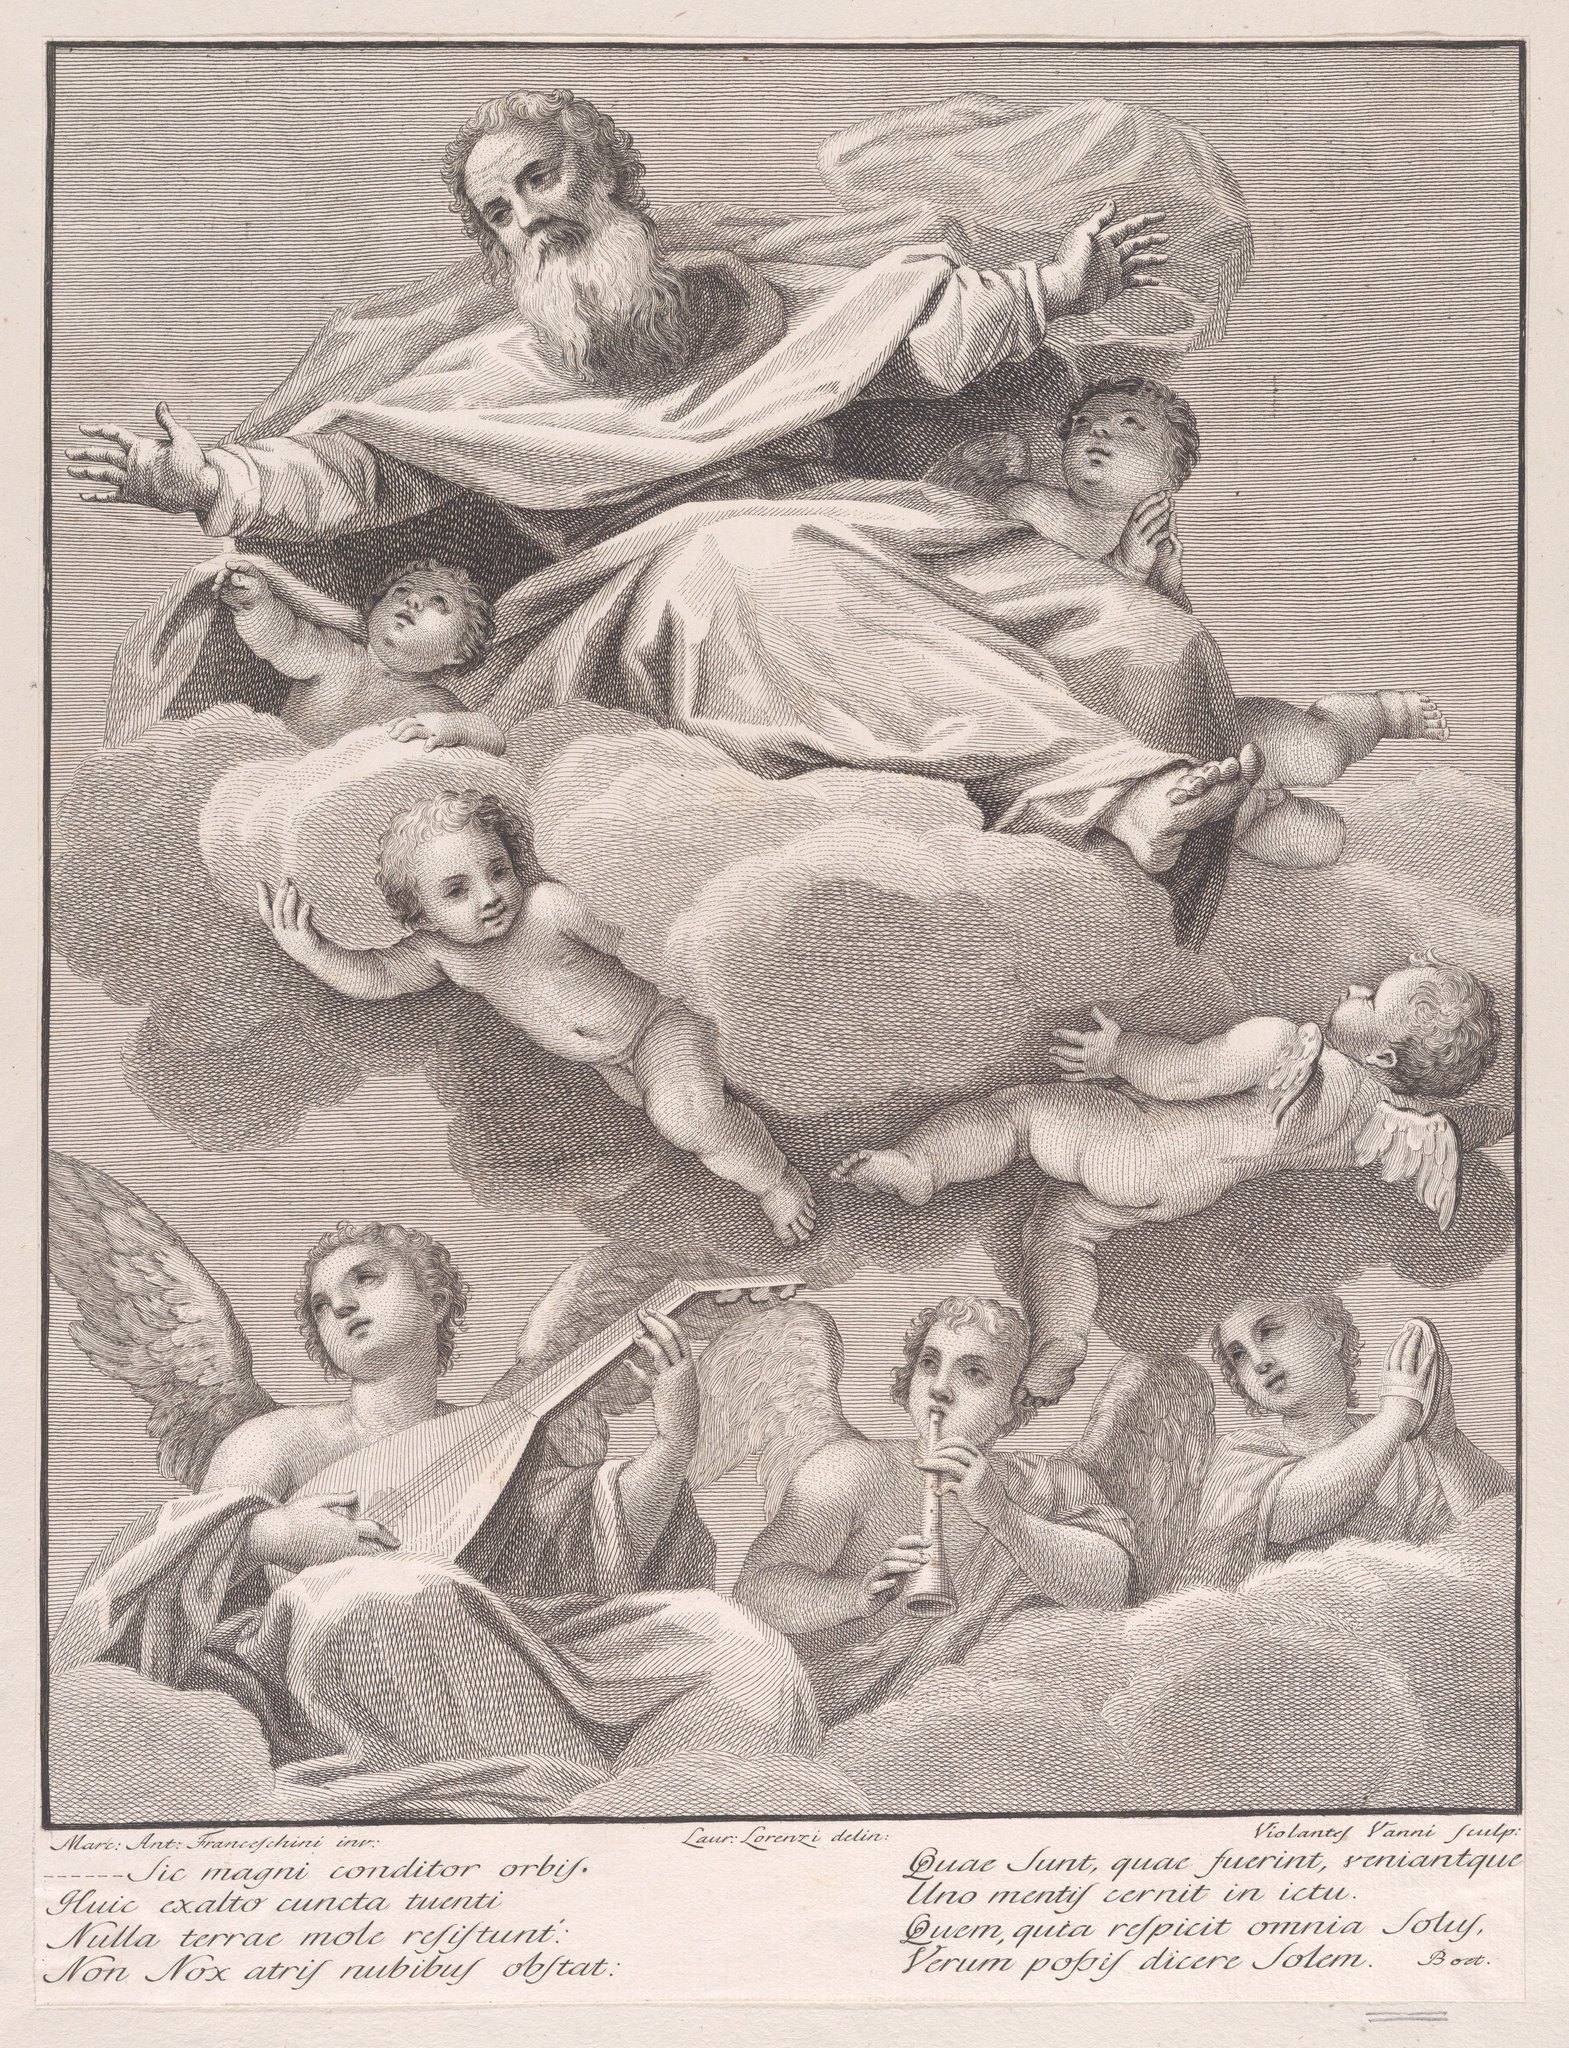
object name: print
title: God with musical angels and cherubim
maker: violante vanni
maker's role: artist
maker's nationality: italian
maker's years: 1732-1776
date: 1774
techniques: engraving, etching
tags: lutes,angels,god the father